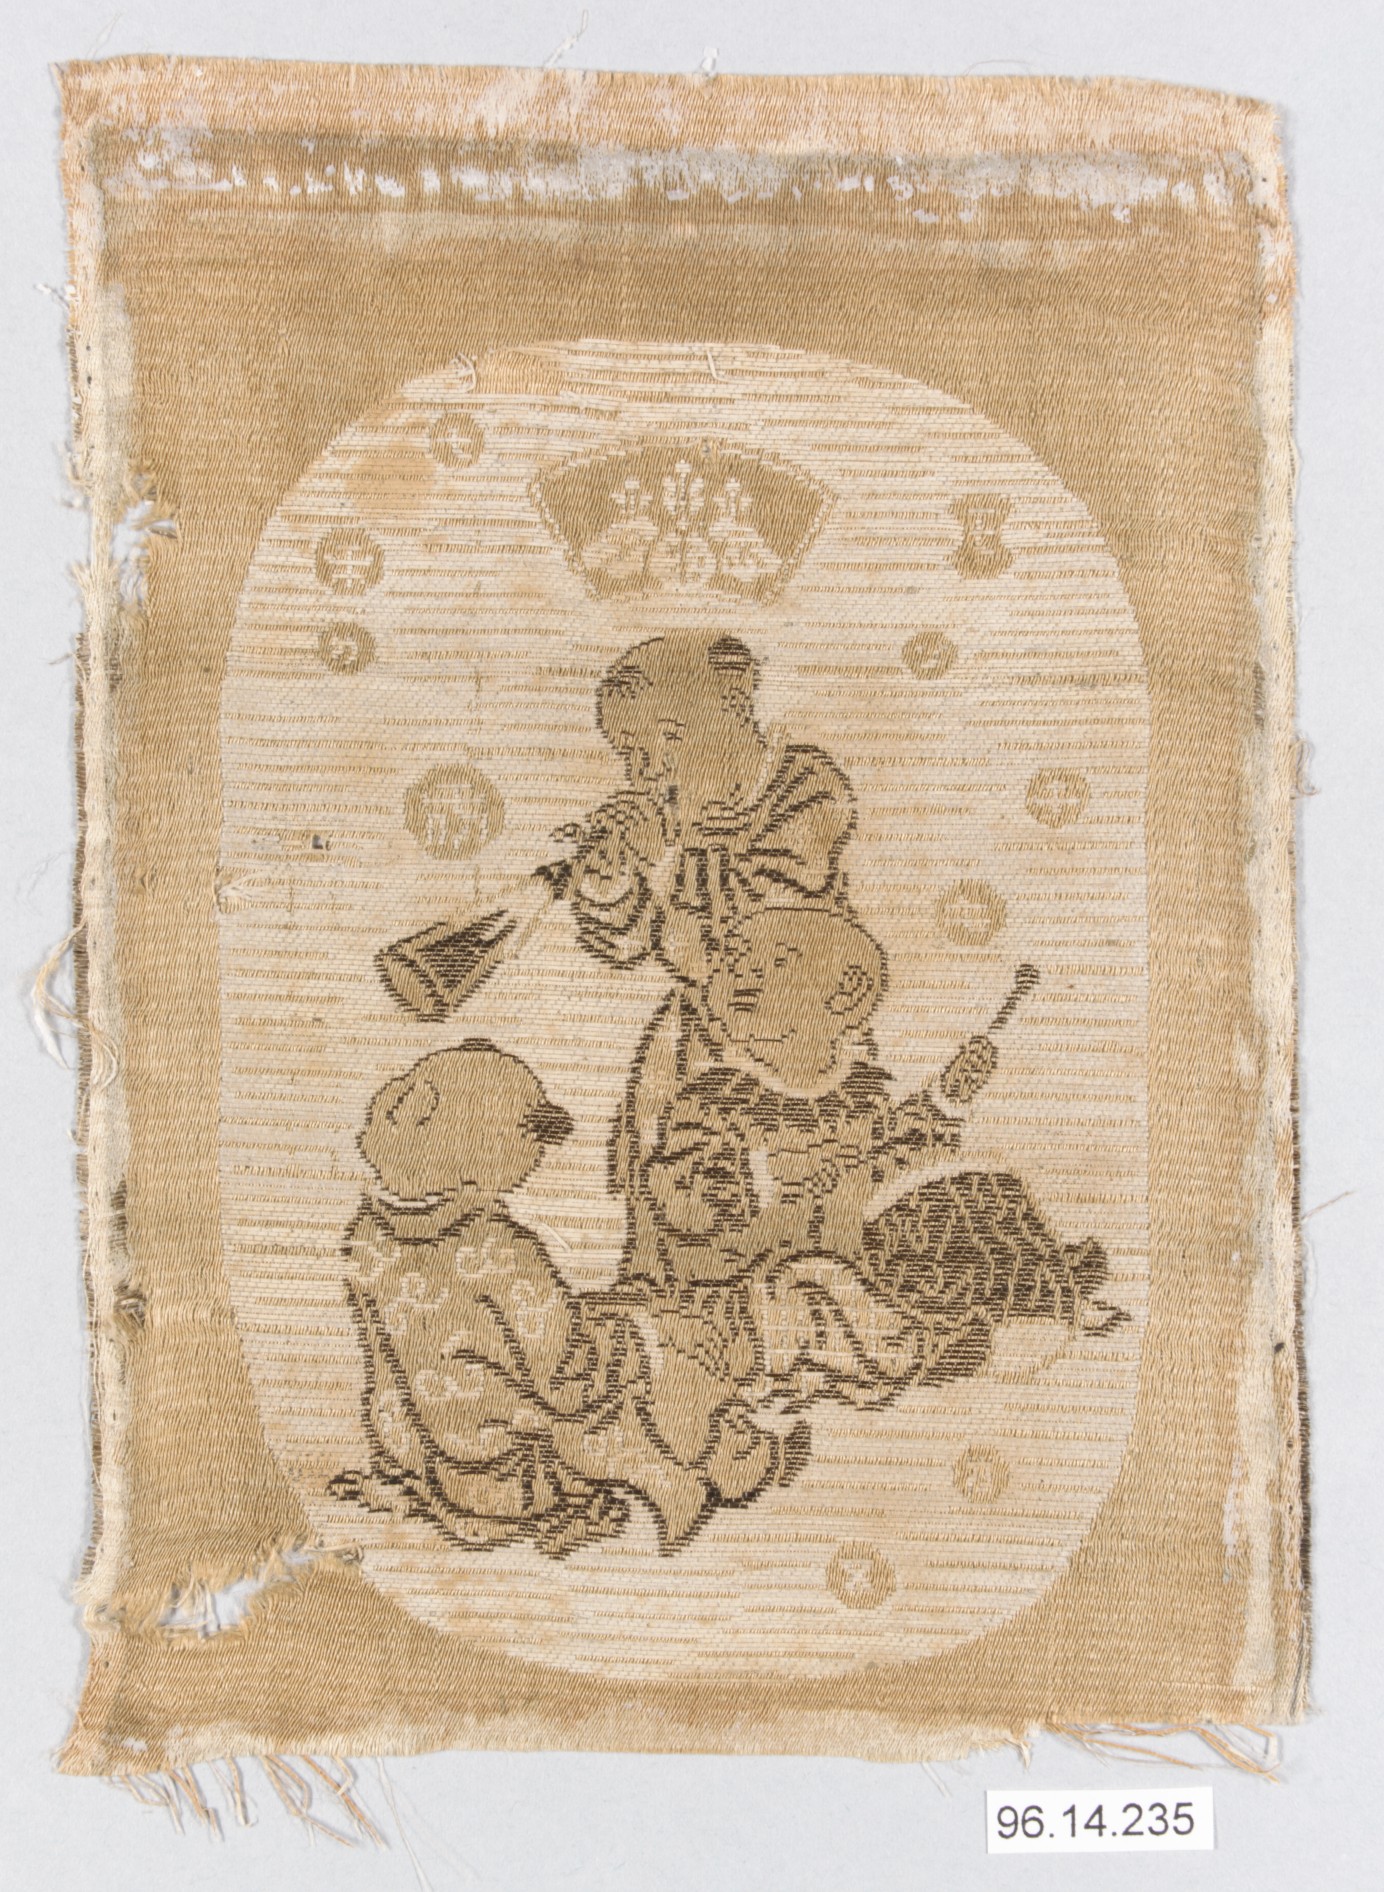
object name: piece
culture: japanese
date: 1701-1900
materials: silk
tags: musical instruments,music